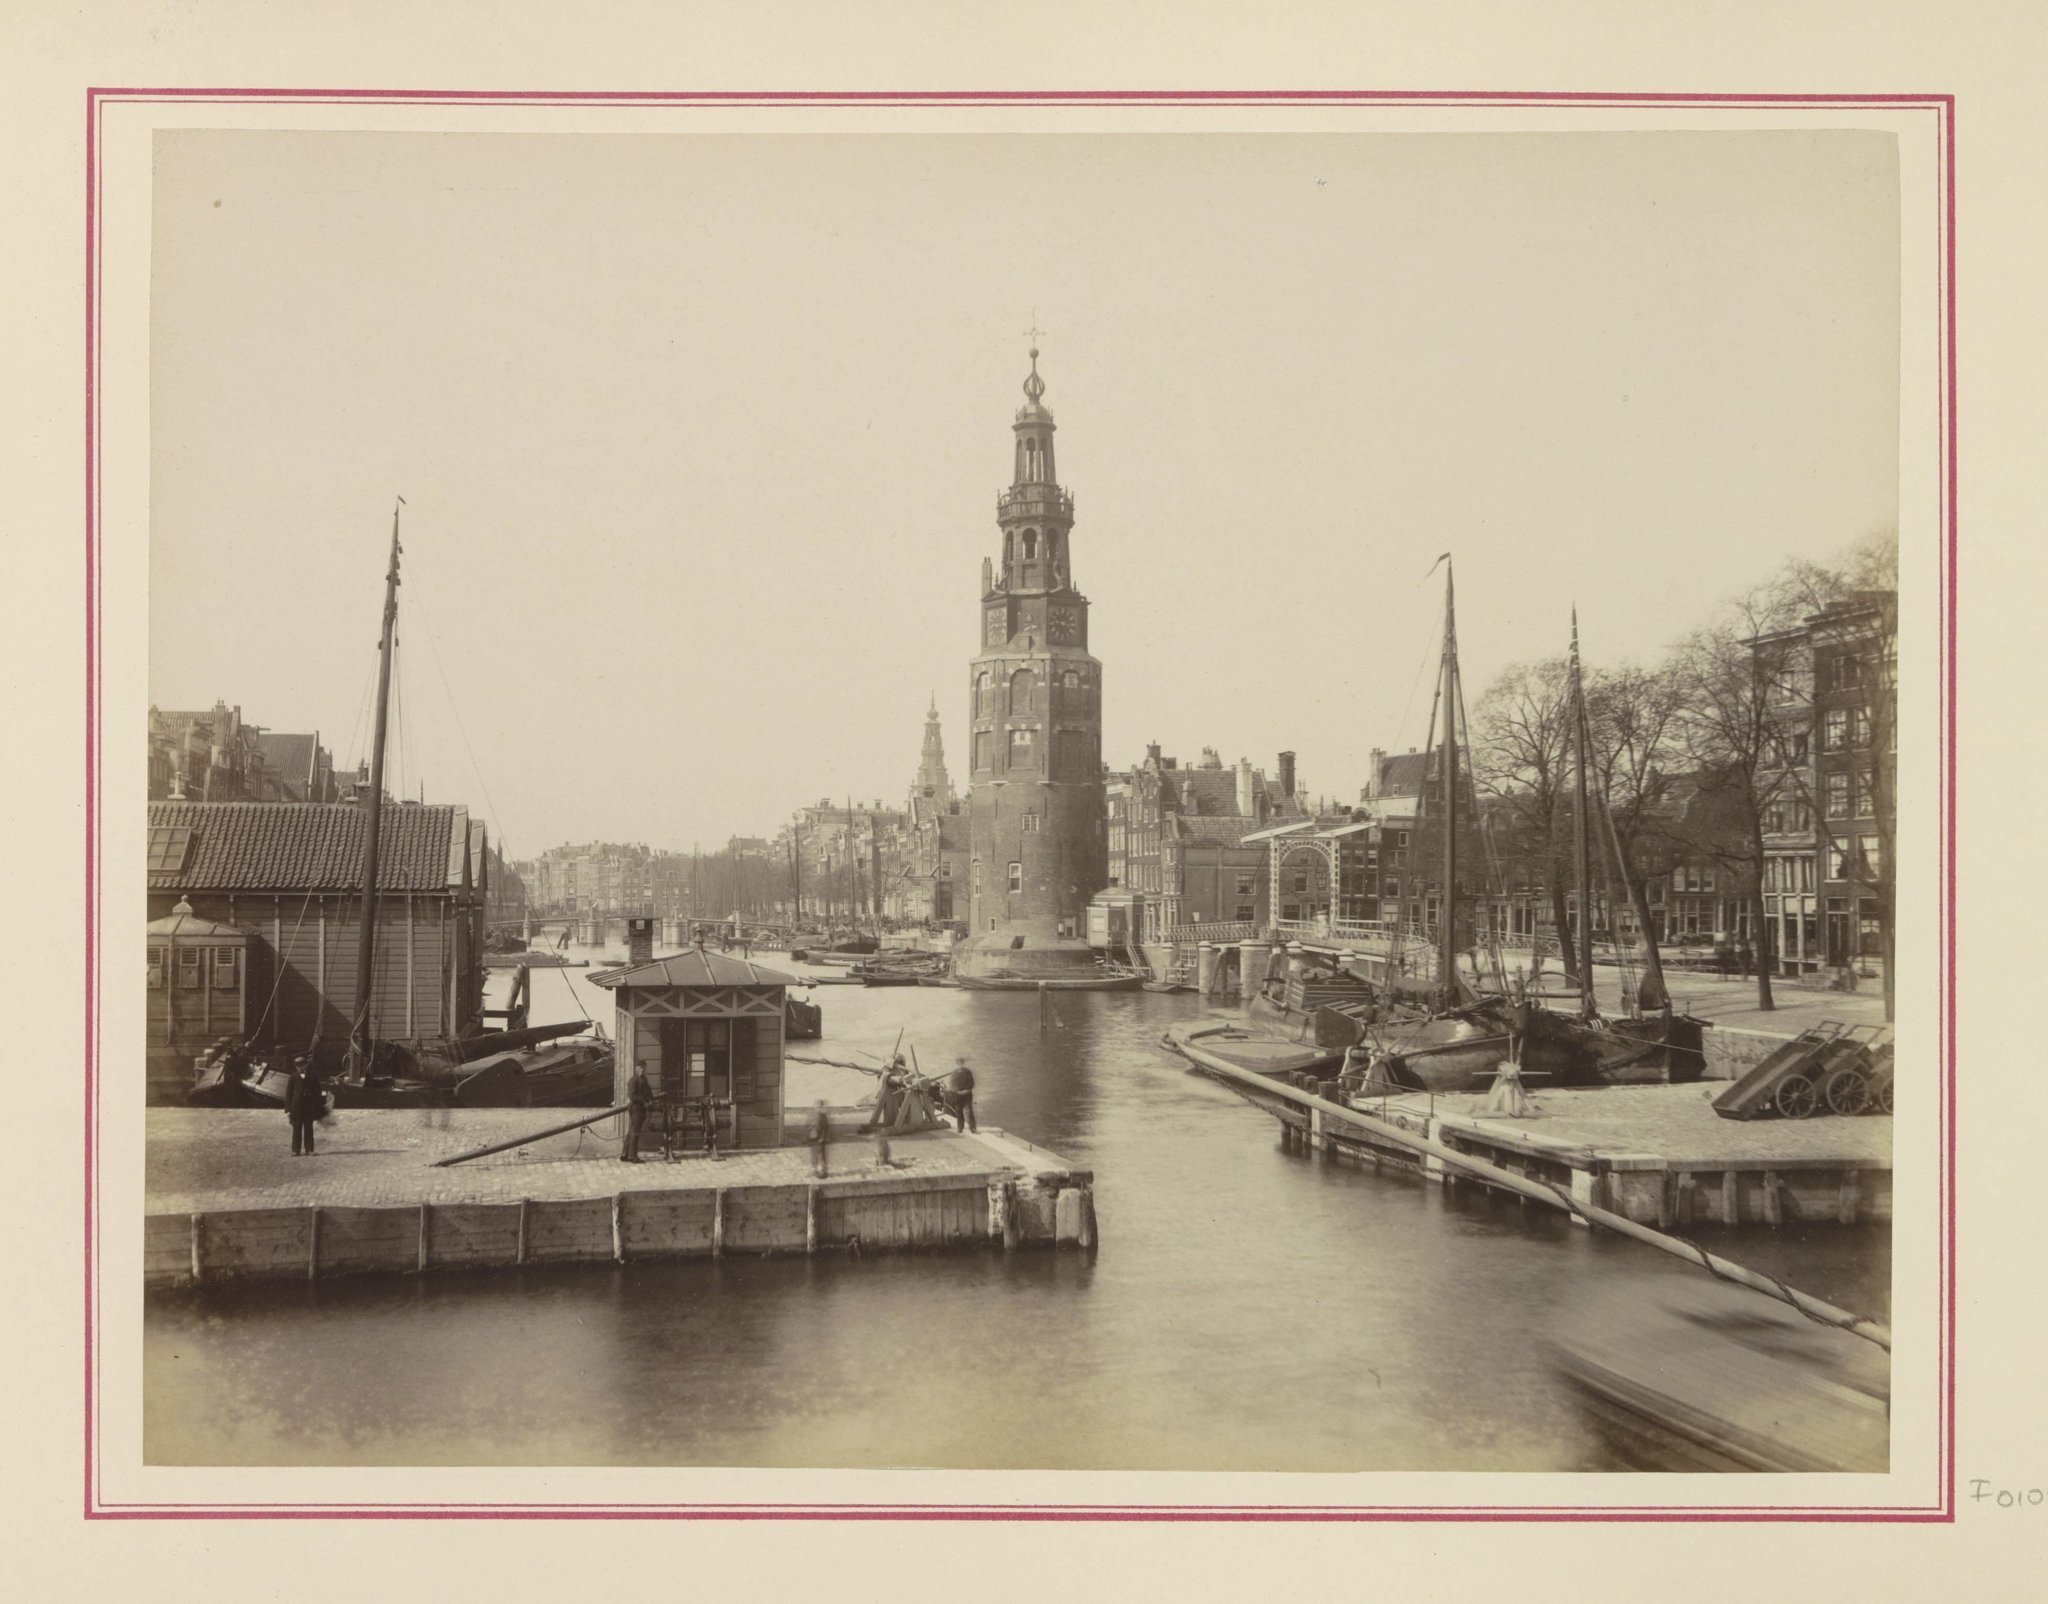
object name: photograph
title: Gezicht op de Oude Schans in Amsterdam met centraal de Montelbaanstoren en de Kikkerbilsluis op de voorgrond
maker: Anonymous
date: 1890-1900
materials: photographic support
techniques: albumen print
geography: amsterdam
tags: sluice, weir, hand-cart, towers ~ fortified city, canals, waters (in city)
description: Onderdeel van Fotoalbum met opnames van bezienswaardigheden in Amsterdam.